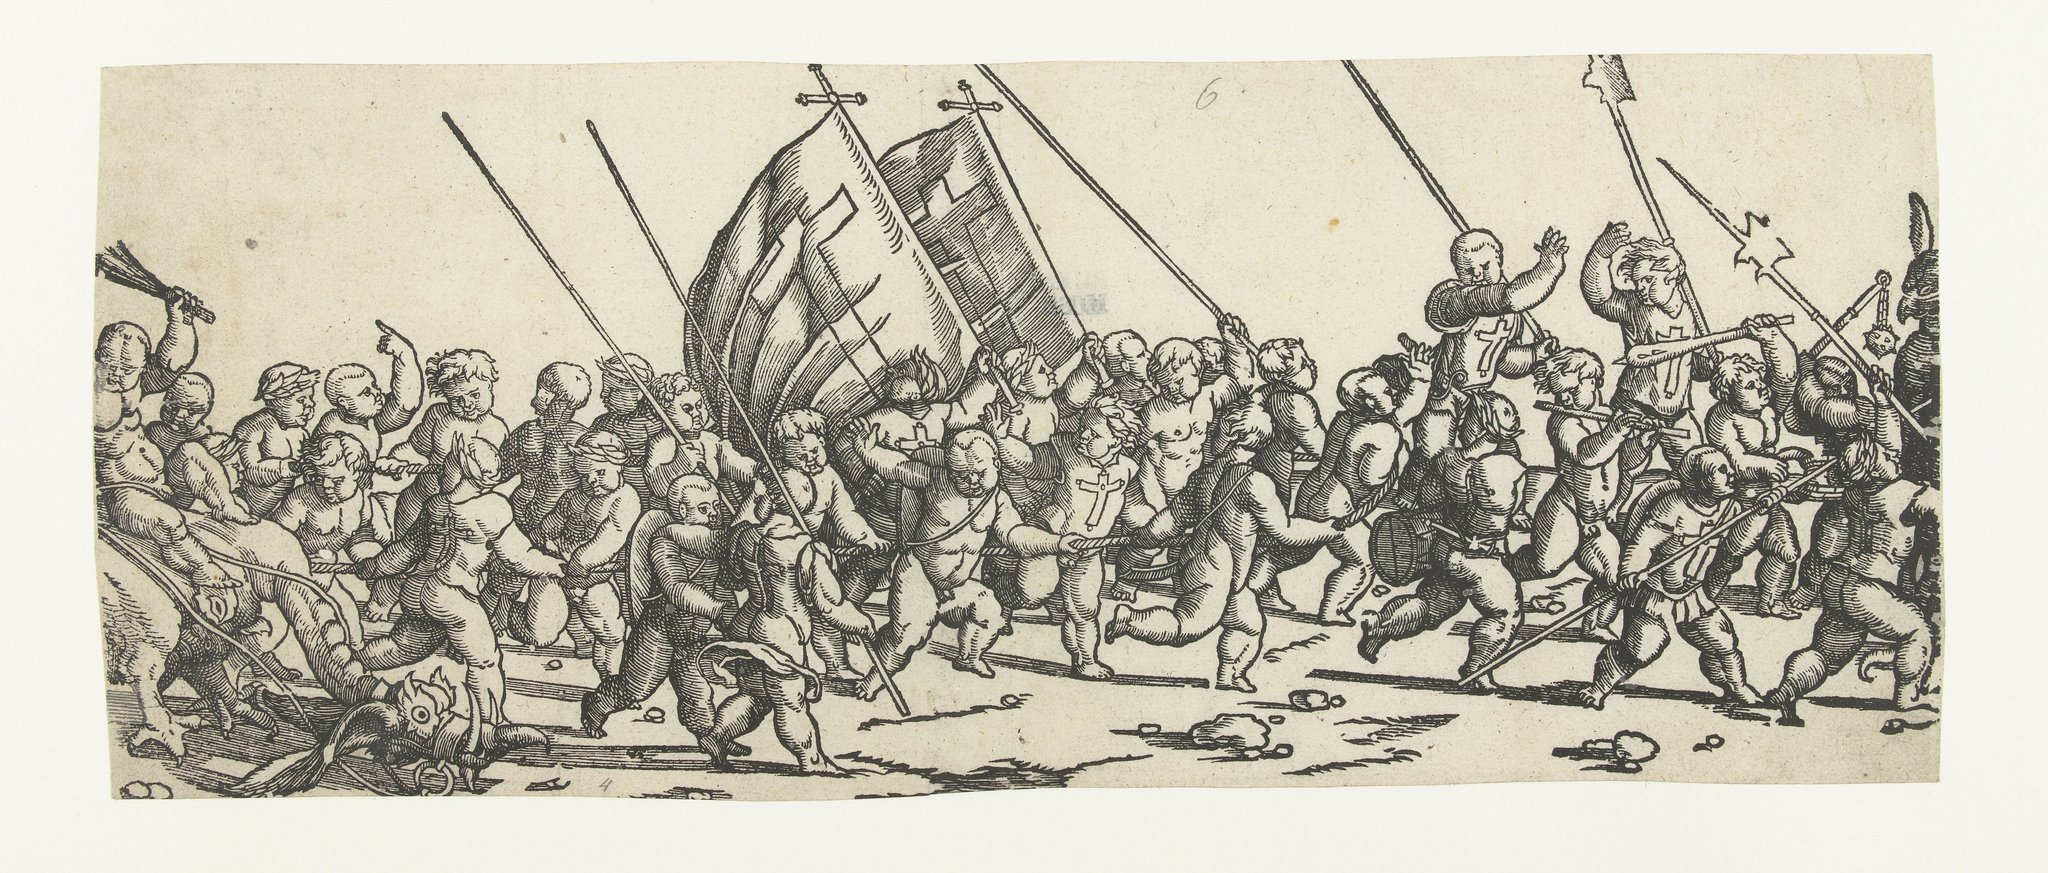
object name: print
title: Kinderkruistocht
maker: monogrammist liw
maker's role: print maker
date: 1522-1532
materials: paper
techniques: woodcut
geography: low countries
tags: child, christian religion (+ devil(s)), militant proselytizing: religious war, crusade, etc.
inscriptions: collector's mark: Lugt 2166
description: Vijfde blok van zes, vormen samen een fries met de kinderkruistocht. Optocht van kinderen met wapens, vlaggen en muziekinstrumenten. Eén kind berijdt een duivel.